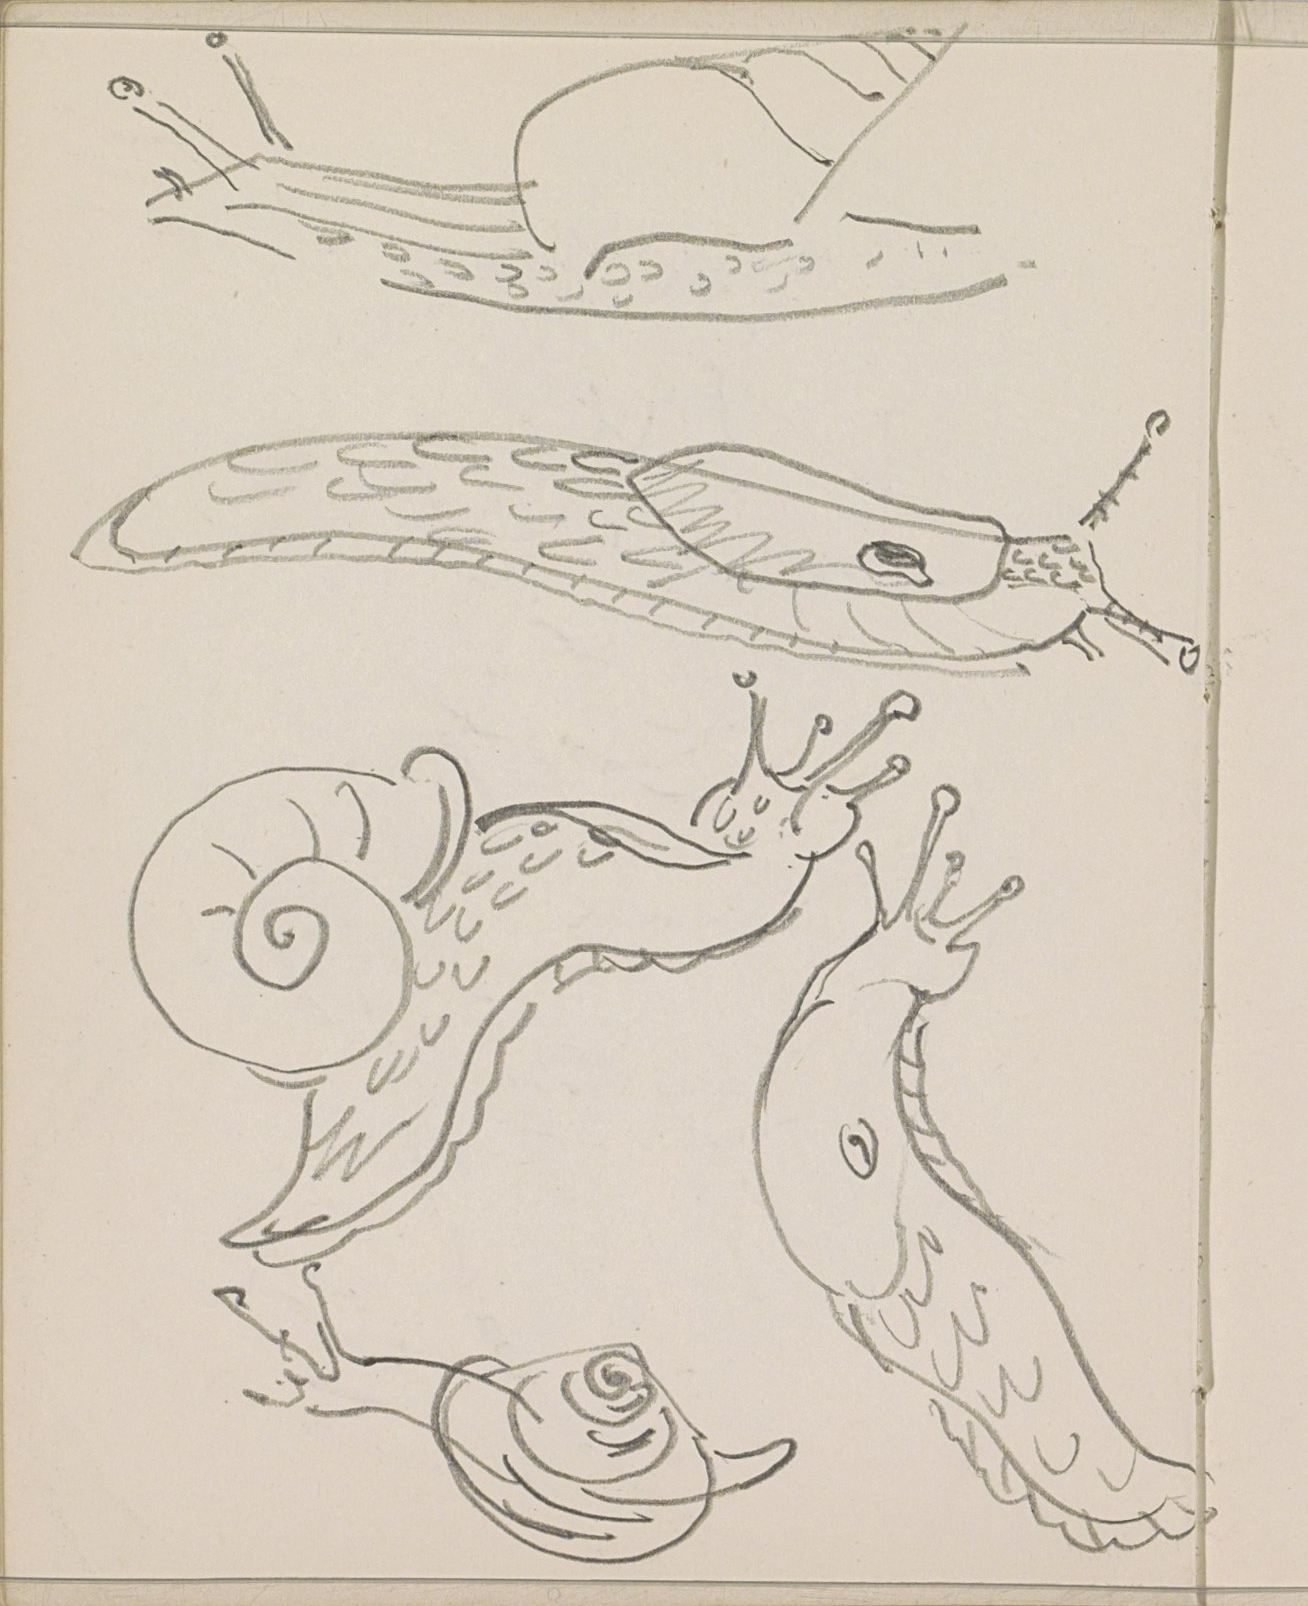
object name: sketchbook leaf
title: Slakken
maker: reijer stolk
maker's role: draughtsman, print maker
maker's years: 1896-1945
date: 1916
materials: paper, pencil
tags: molluscs: snail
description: Blad 26 verso uit een schetsboek met 72 bladen.